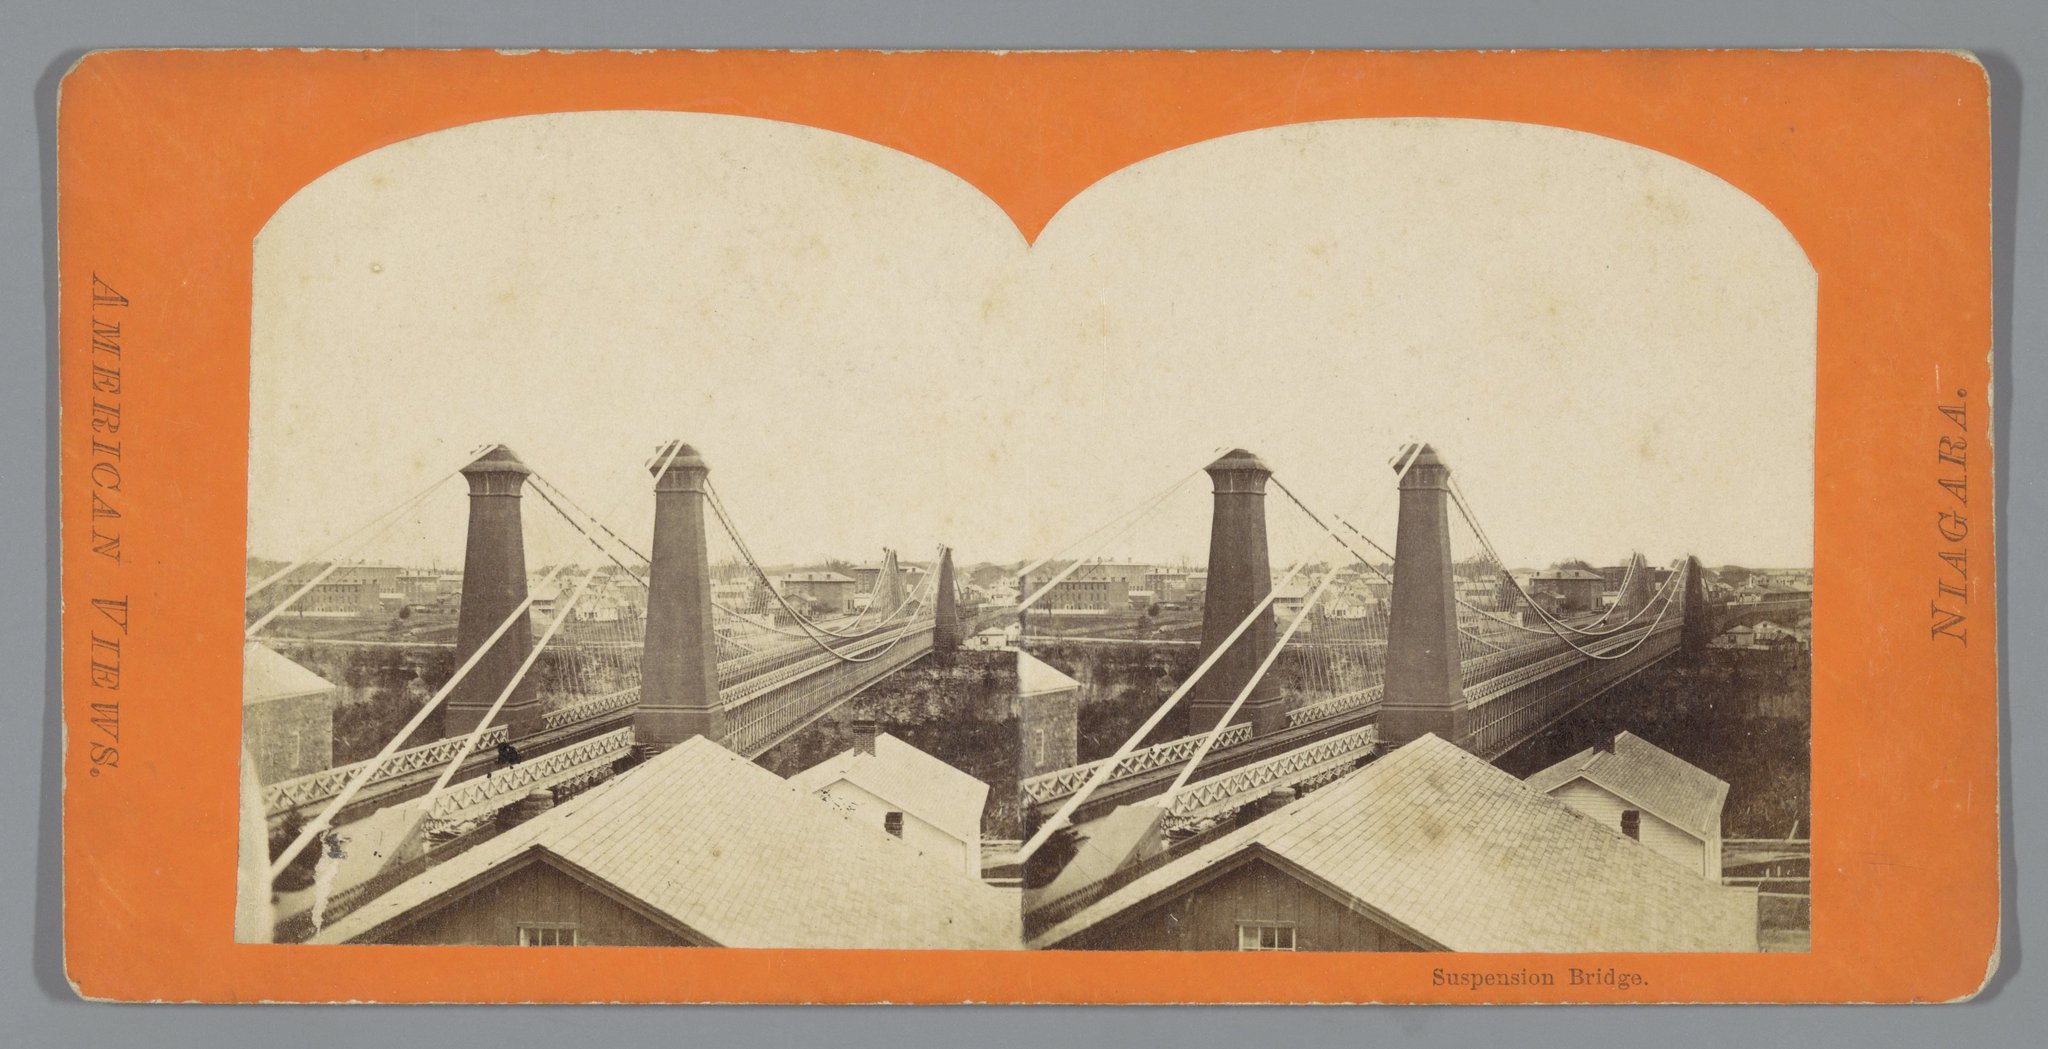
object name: stereograph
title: Suspension Bridge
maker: Anonymous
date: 1868-1890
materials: cardboard, paper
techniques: albumen print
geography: niagara falls suspension bridge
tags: suspension bridge